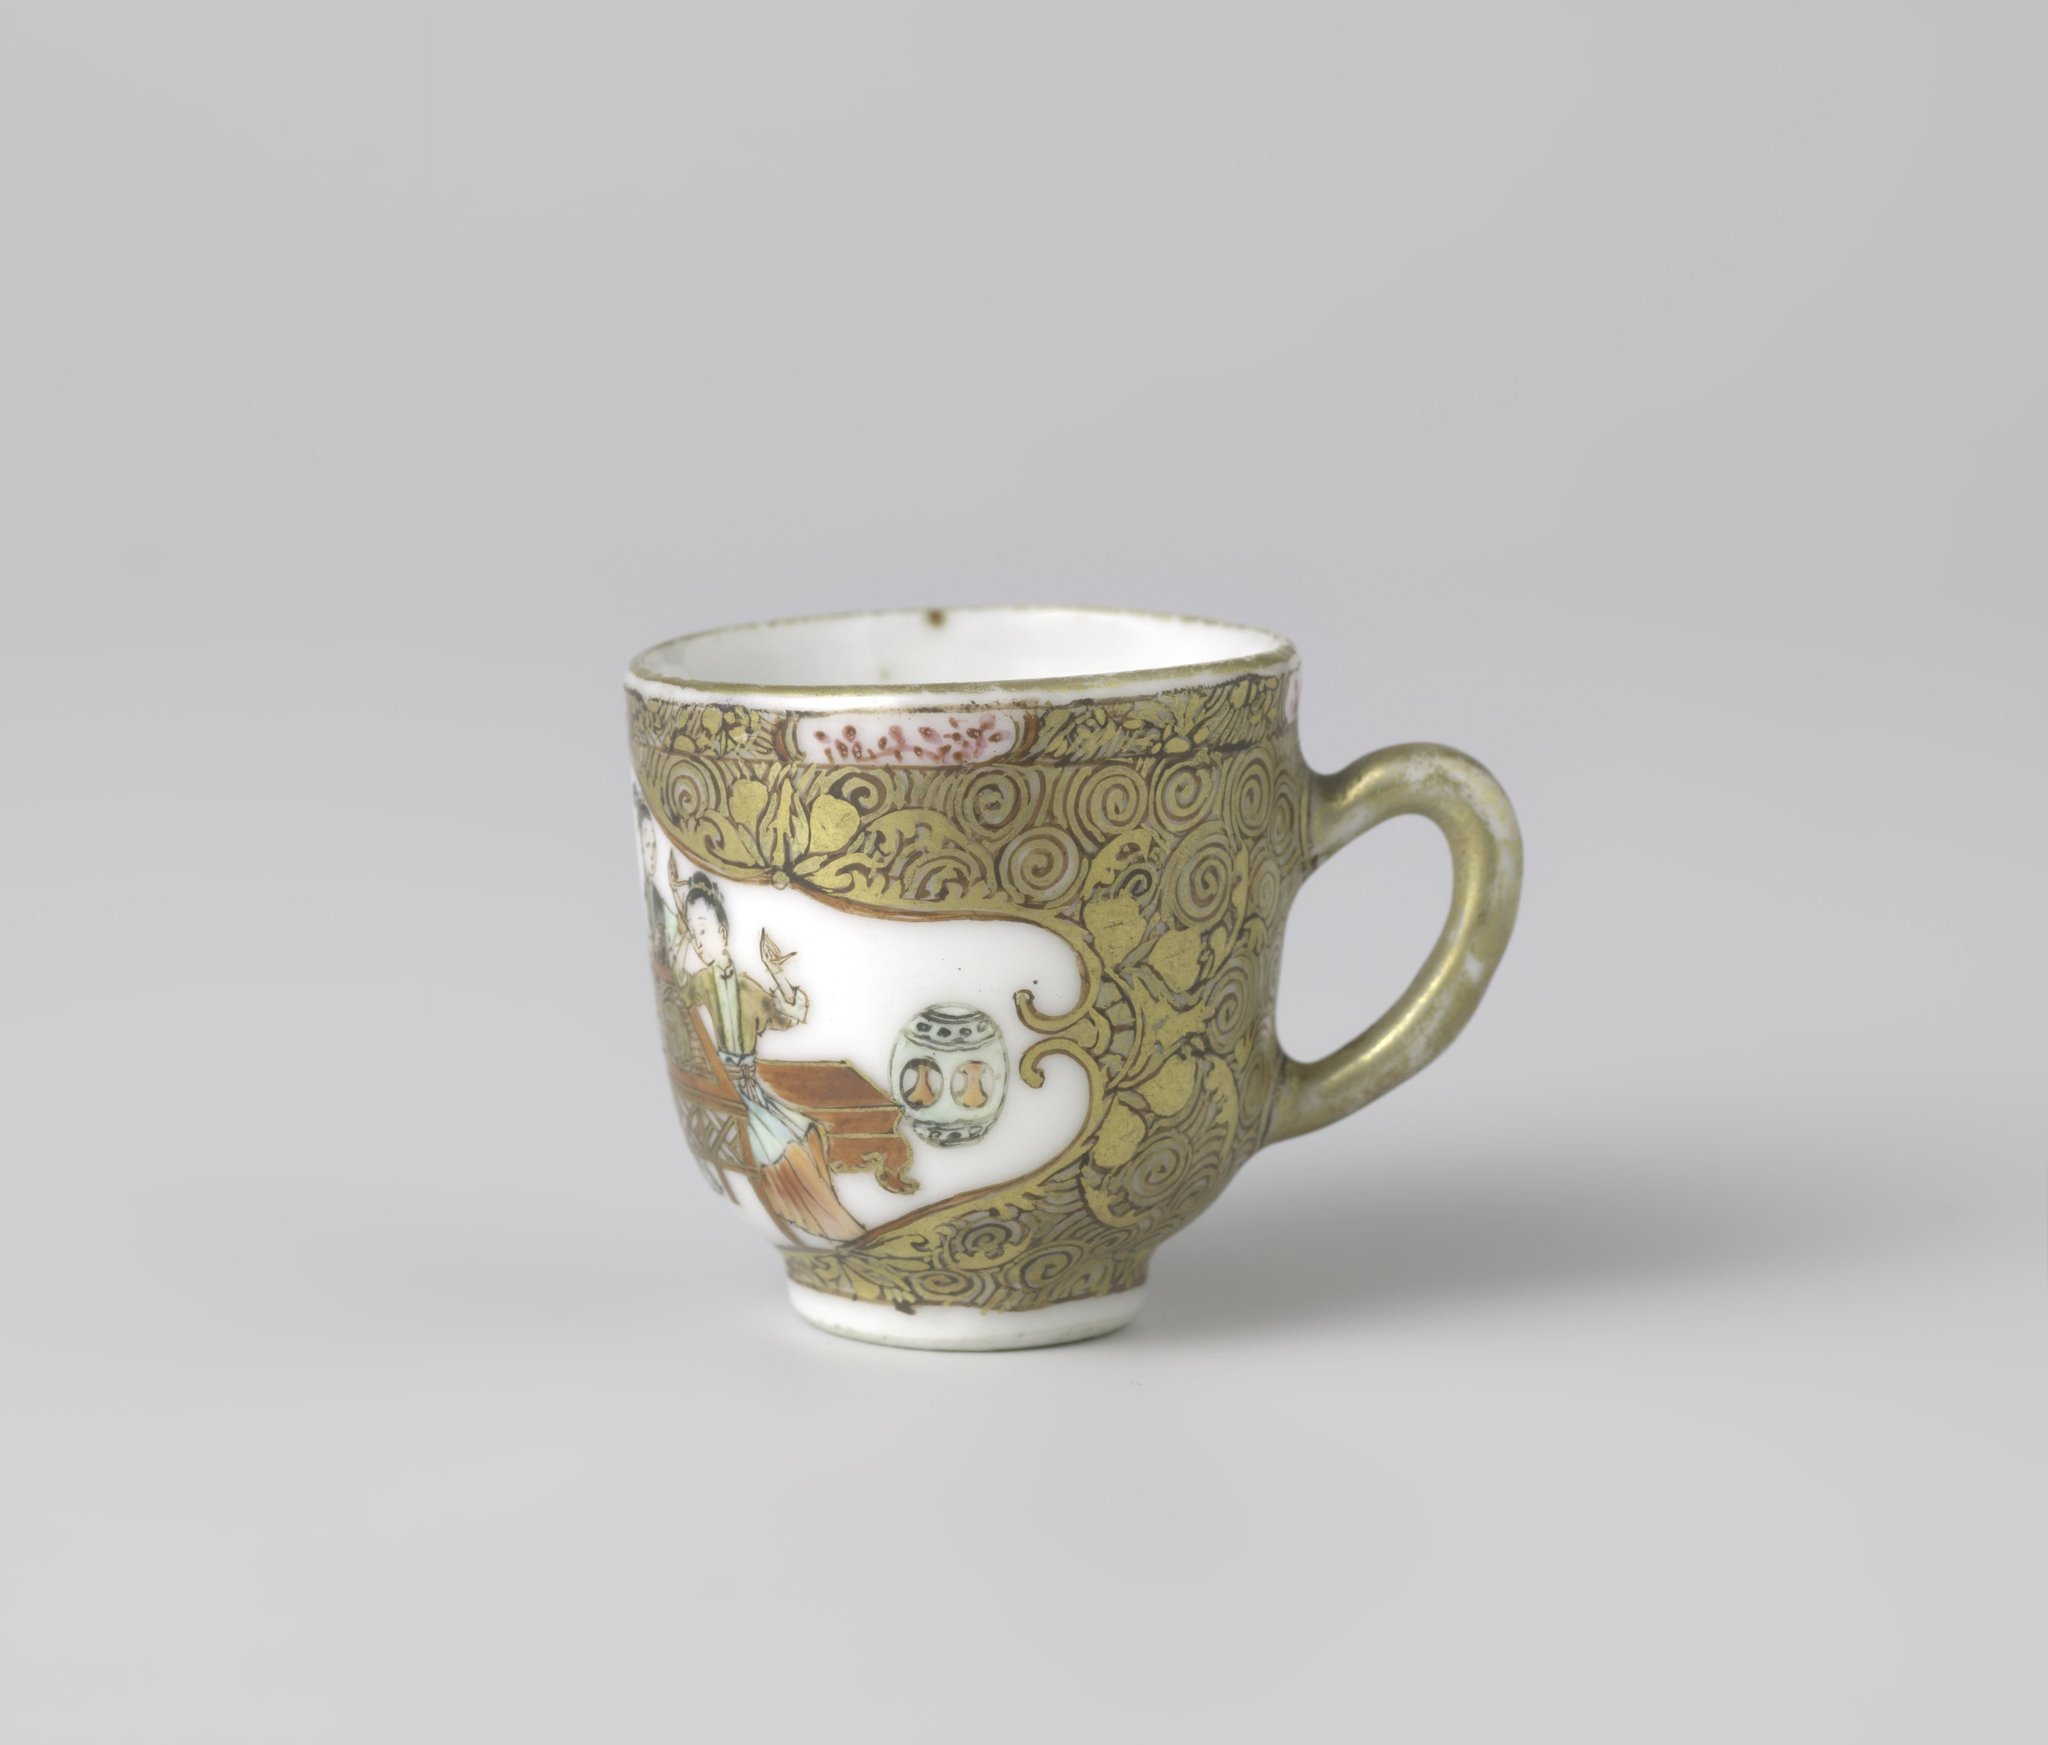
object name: cup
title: Cup with handle with three women in a panel on a ground of scrolls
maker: Anonymous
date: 1750-1774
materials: glaze, gold, paint, porcelain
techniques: firing, gilding, turning, vitrification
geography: china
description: Kleine oorkop van porselein, beschilderd op het glazuur in blauw, rood, roze, groen, geel, zwart en goud. De wand is bedekt met krulwerk en ranken met hierin uitgespaard een cartouche met drie vrouwen om een tafel met naast hen vazen en gelukssymbolen; op de bodem een twijg. Famille rose.